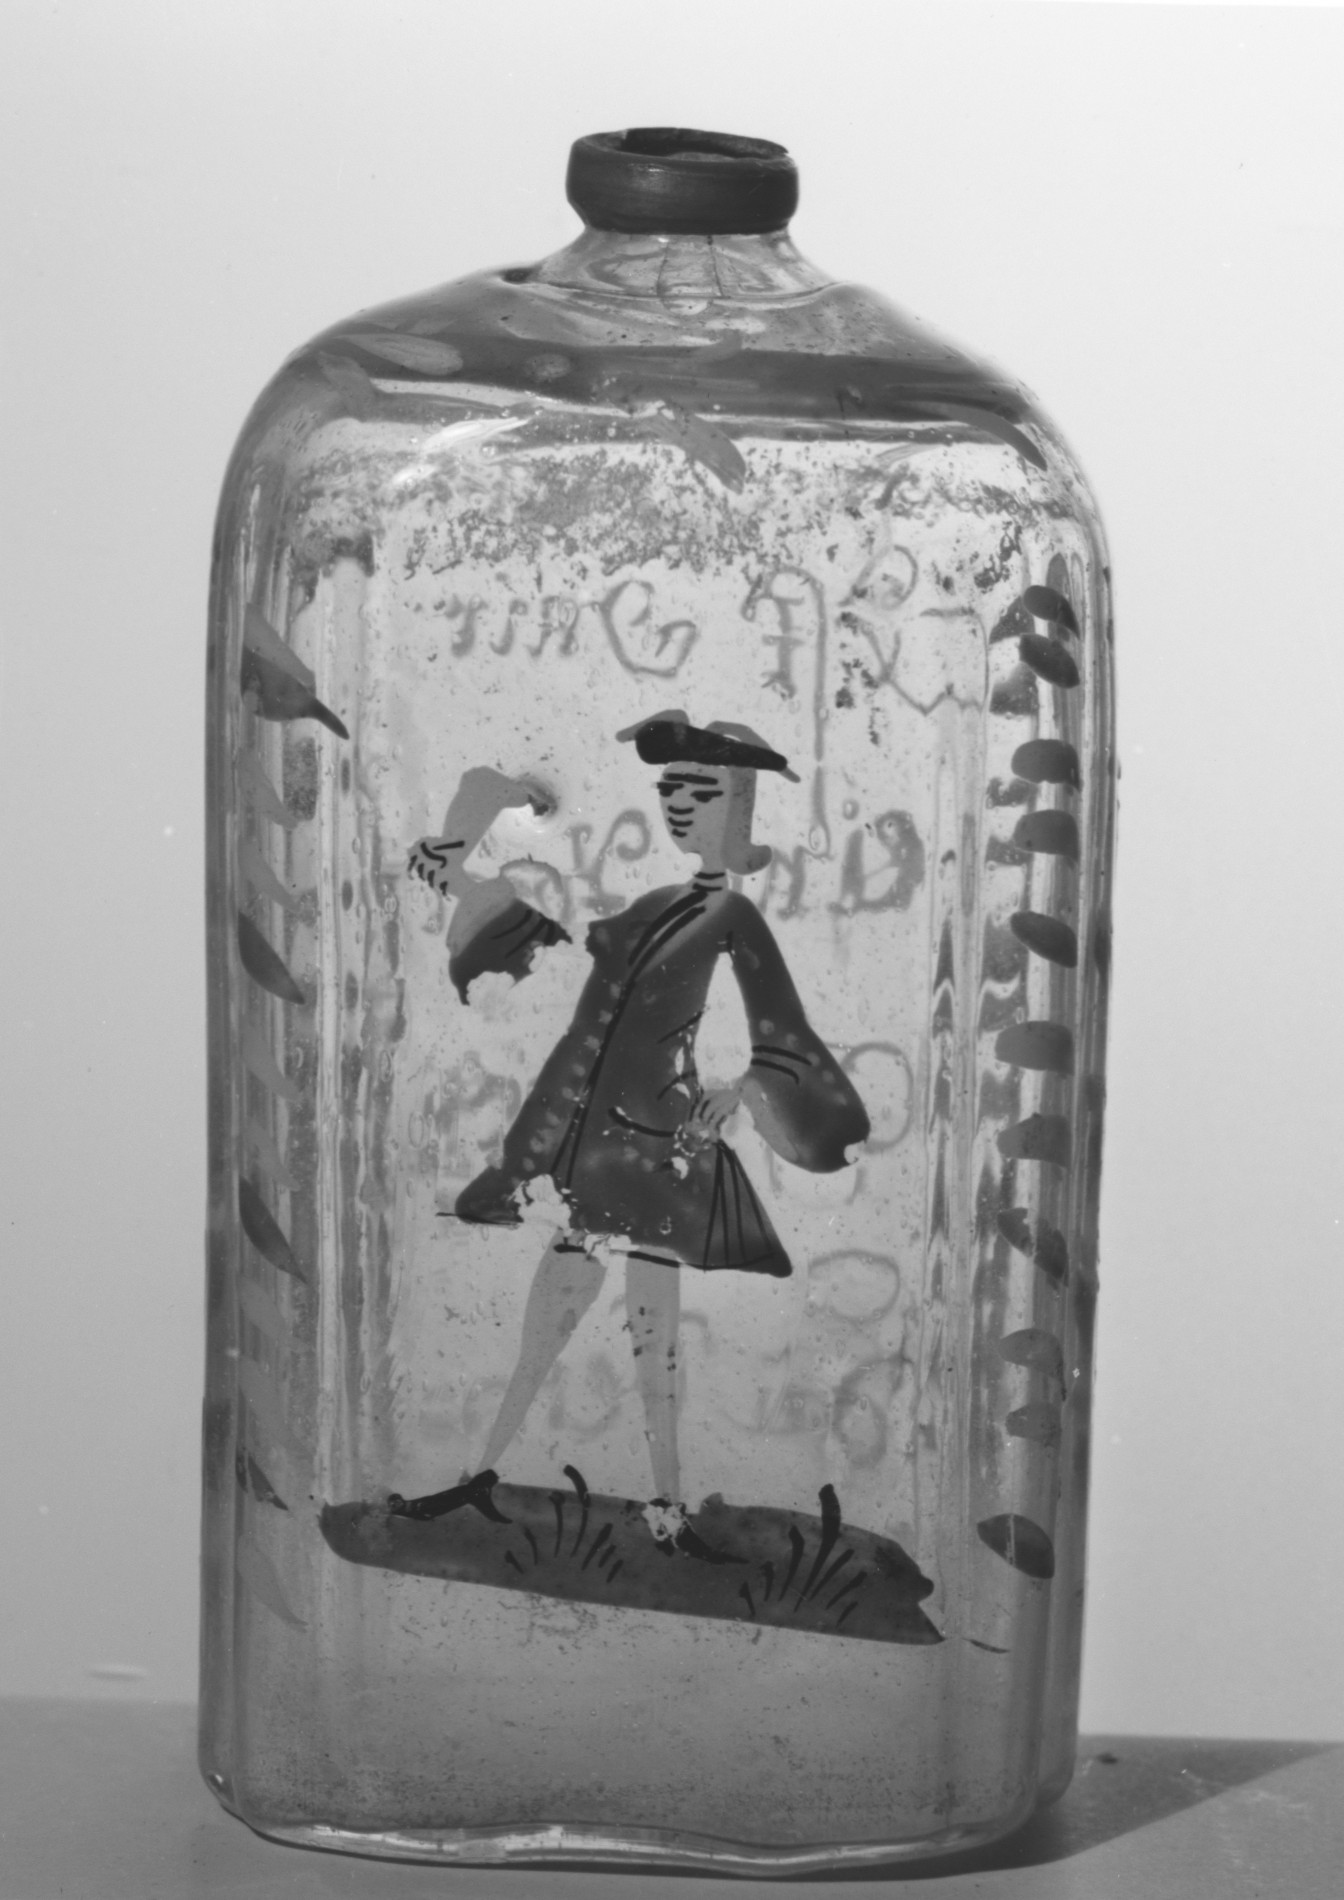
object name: bottle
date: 1701-1800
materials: glass, pewter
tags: human figures